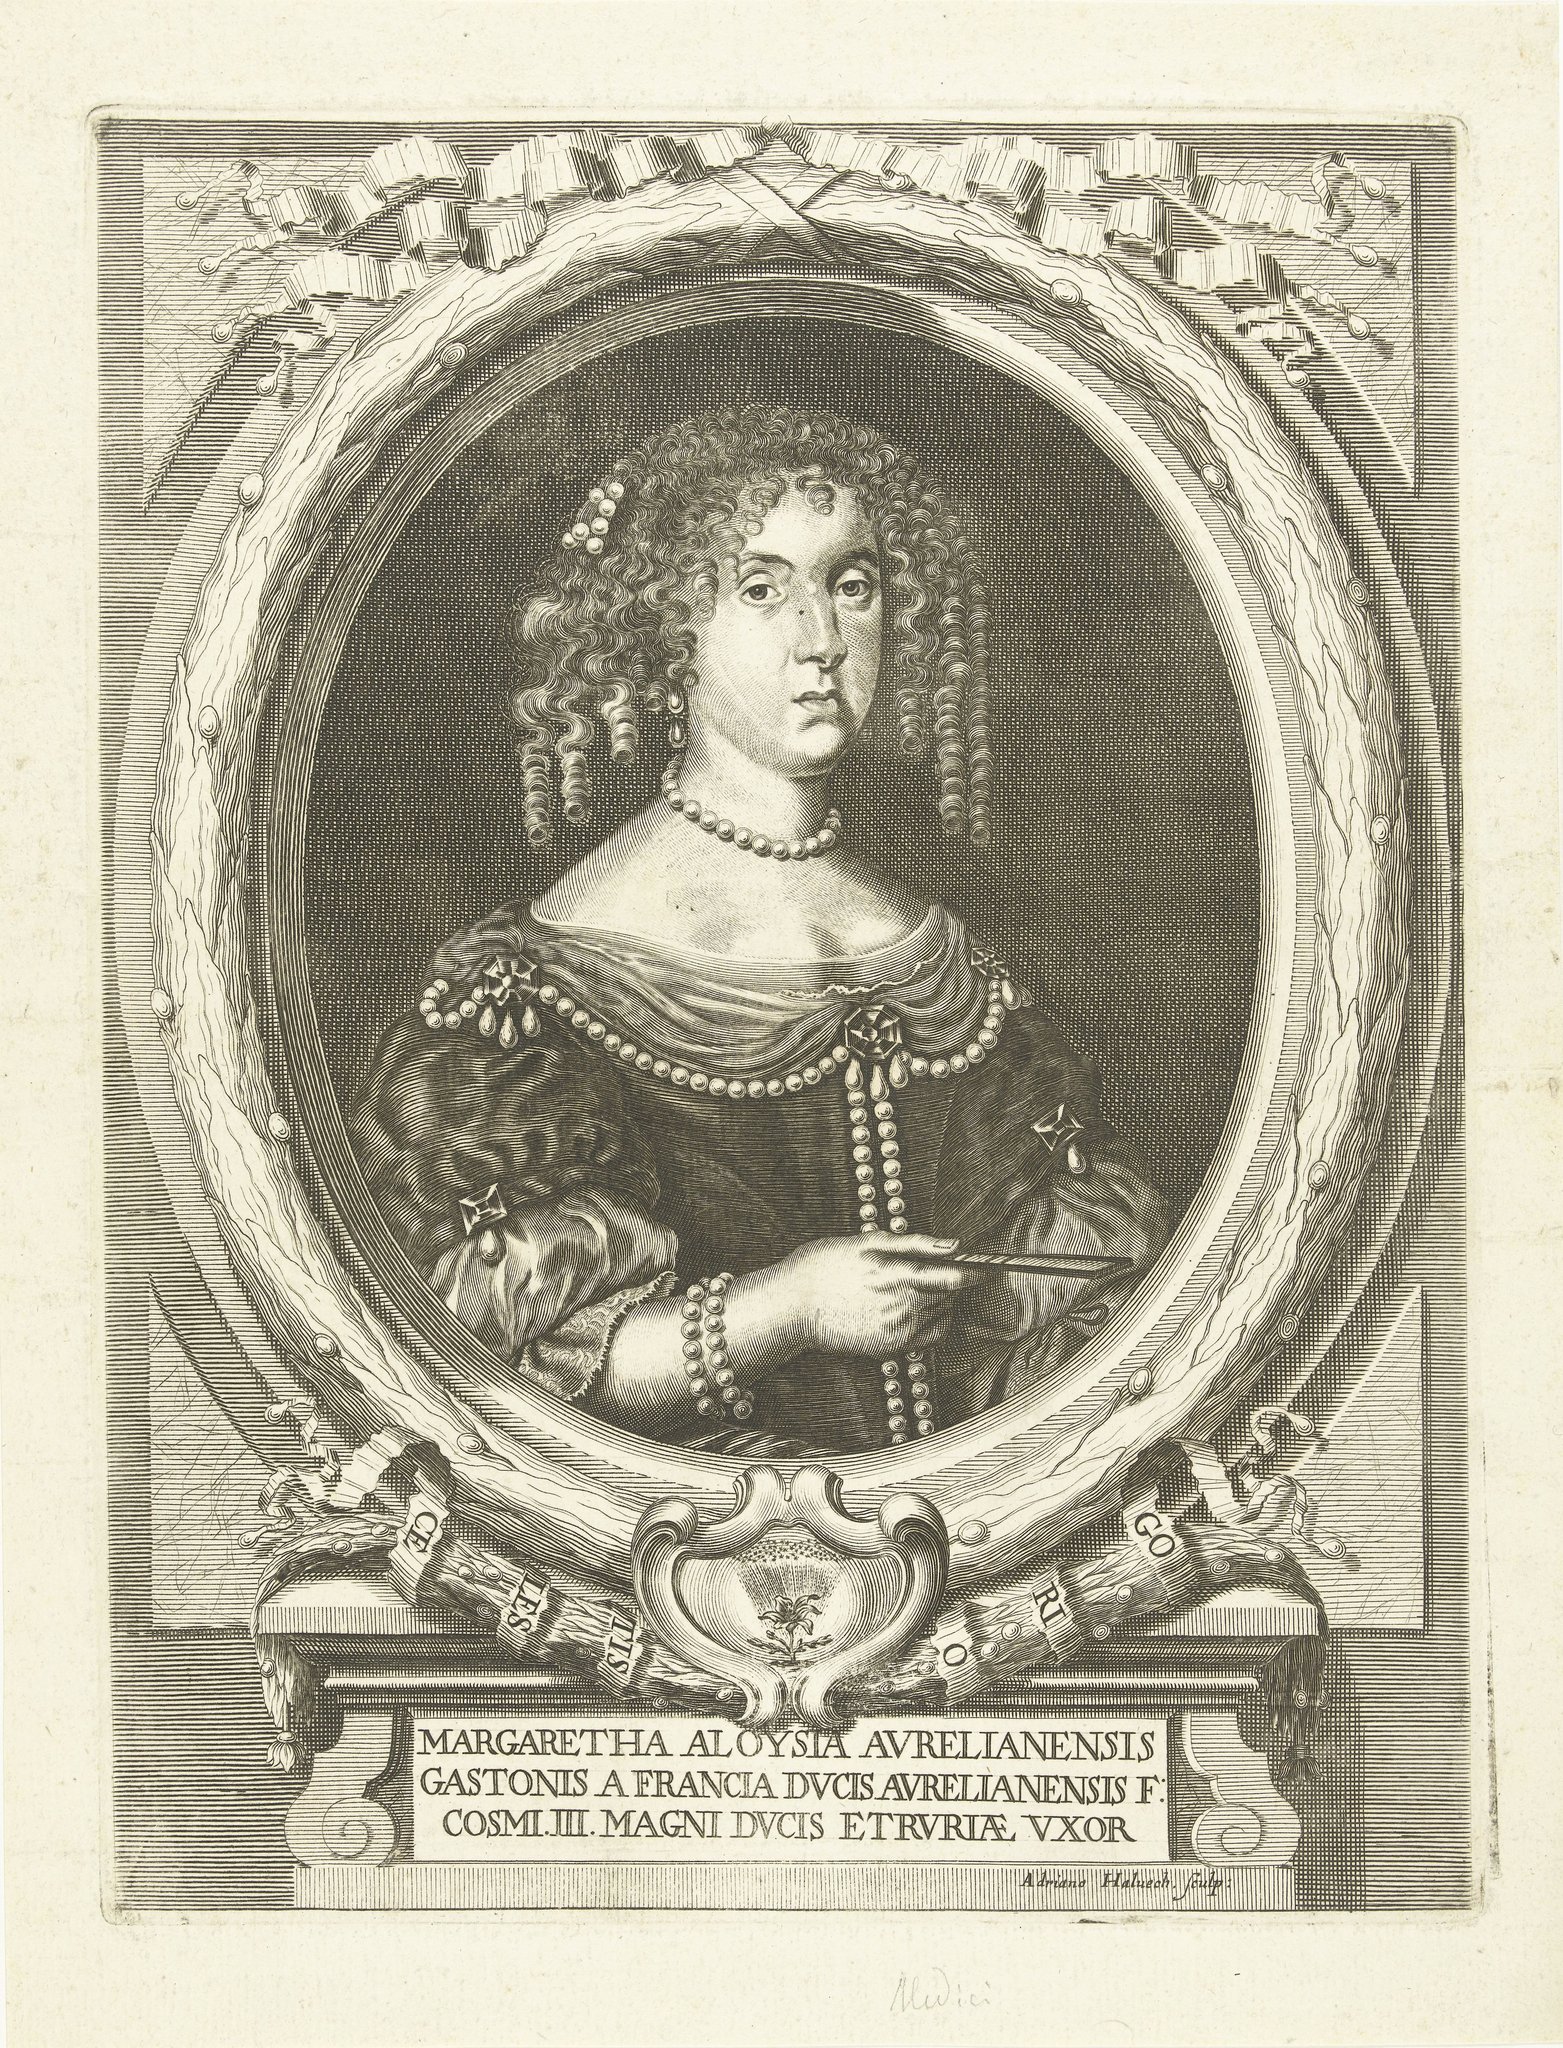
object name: print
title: Portretten van de familie De' Medici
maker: adriaen haelwegh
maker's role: print maker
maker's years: 1637-1702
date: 1647-1696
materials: paper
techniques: engraving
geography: northern netherlands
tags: paris, accessories (~ clothing), fan, pearl; pearl necklace (+ women's clothes)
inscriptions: collector's mark: Lugt 2228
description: Portret ten halven lijve naar rechts van Marguerite Louise van Orléans, dochter van Gaston van Orléans en echtgenote van Cosimo III de Medici, in een ovaal omringd met een lauwerkrans. Onderaan in een cartouche een bloem en een stralenkrans. Daaronder op een tablet onder een plint haar naam en twee regels in Latijn.